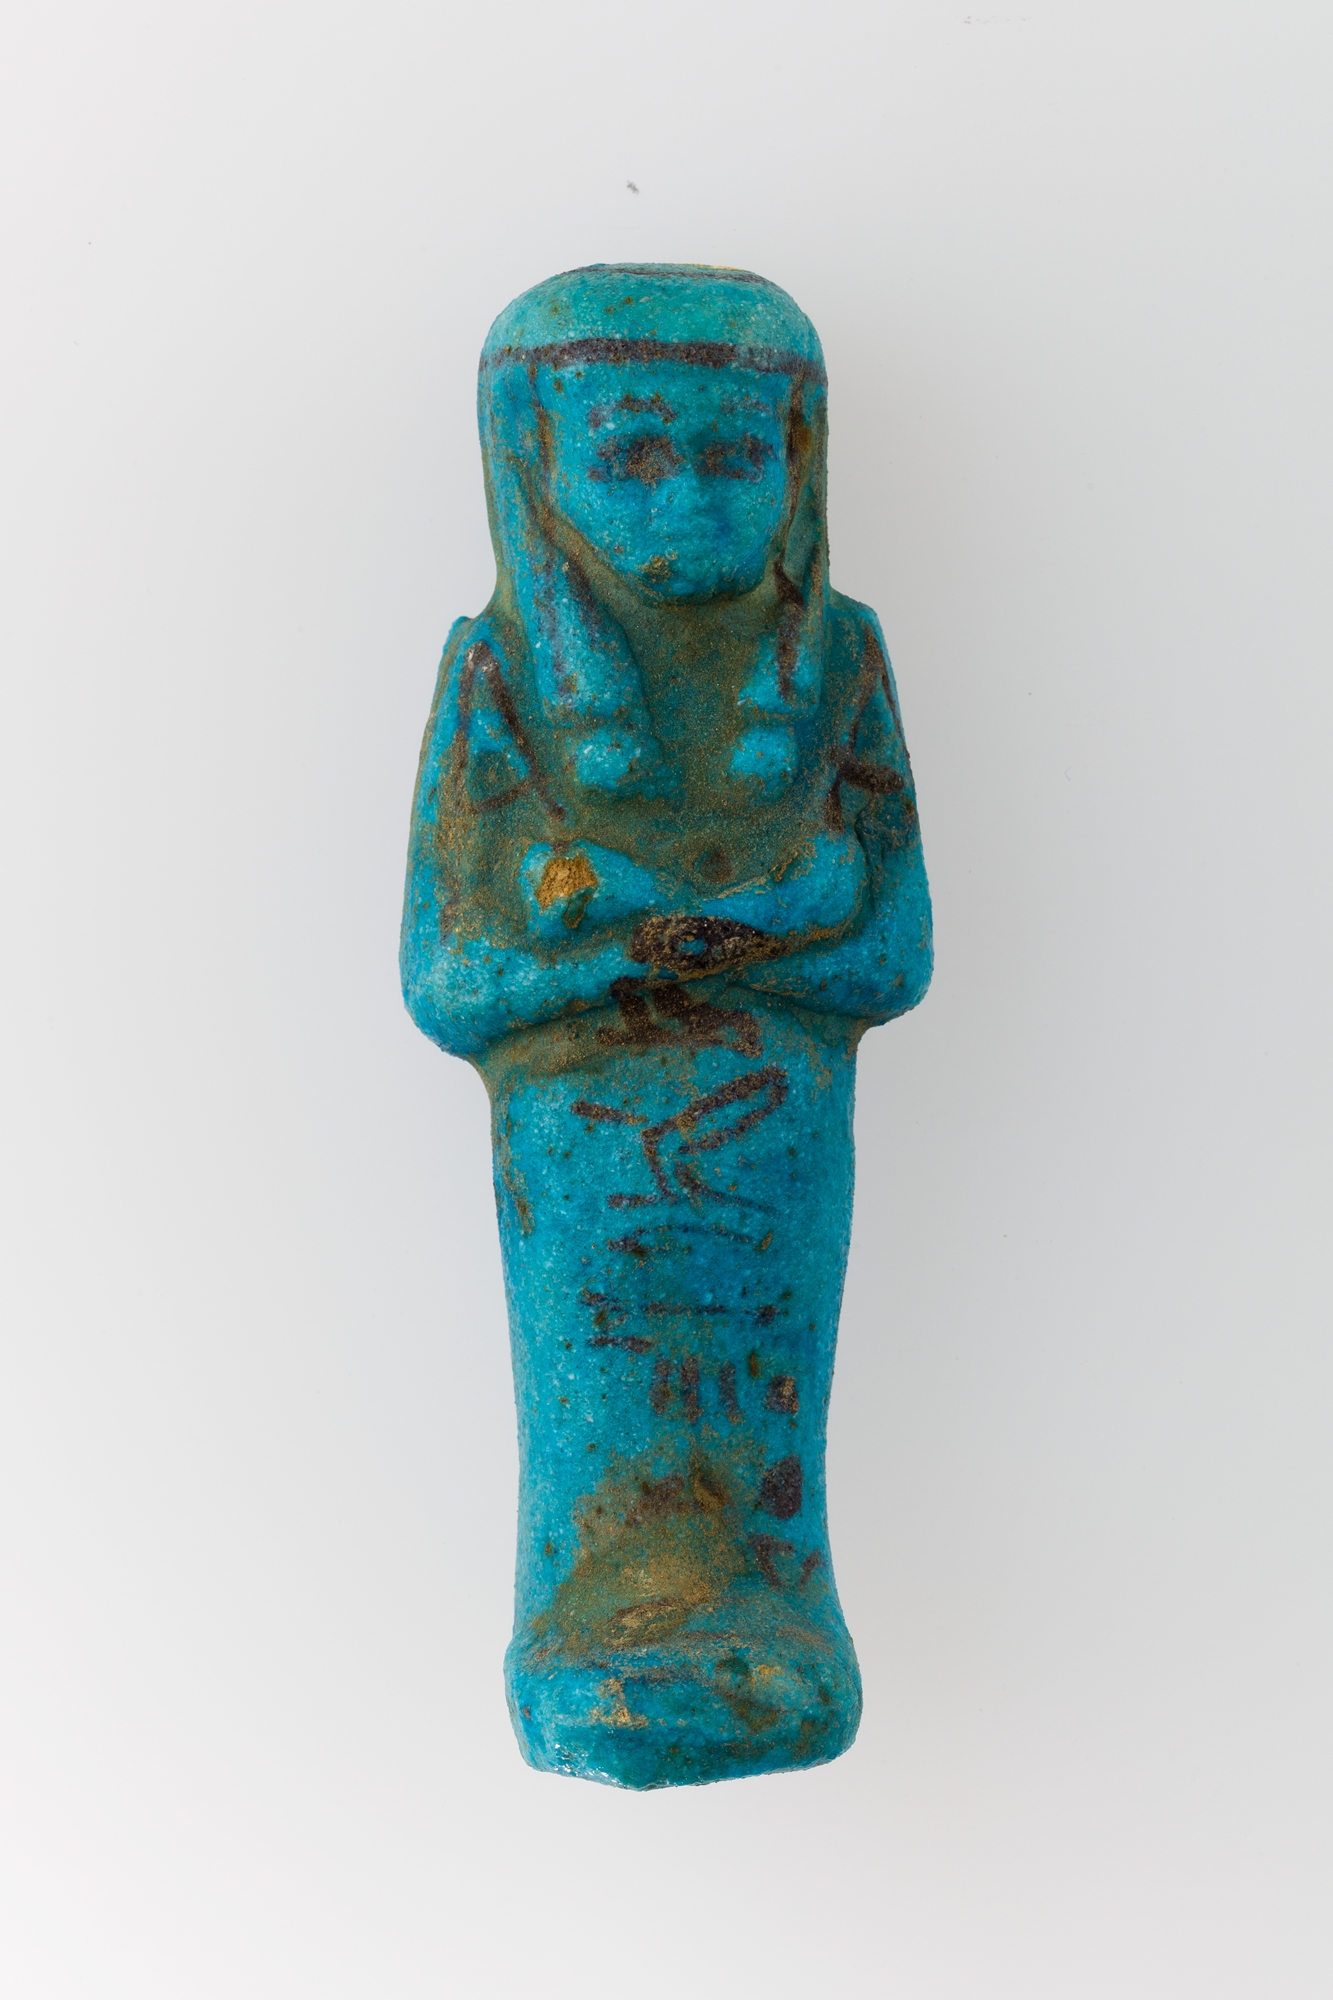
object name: shabti, henettawy c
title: Worker Shabti of Henettawy (C), Daughter of Isetemkheb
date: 990-970 BCE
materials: faience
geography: egypt